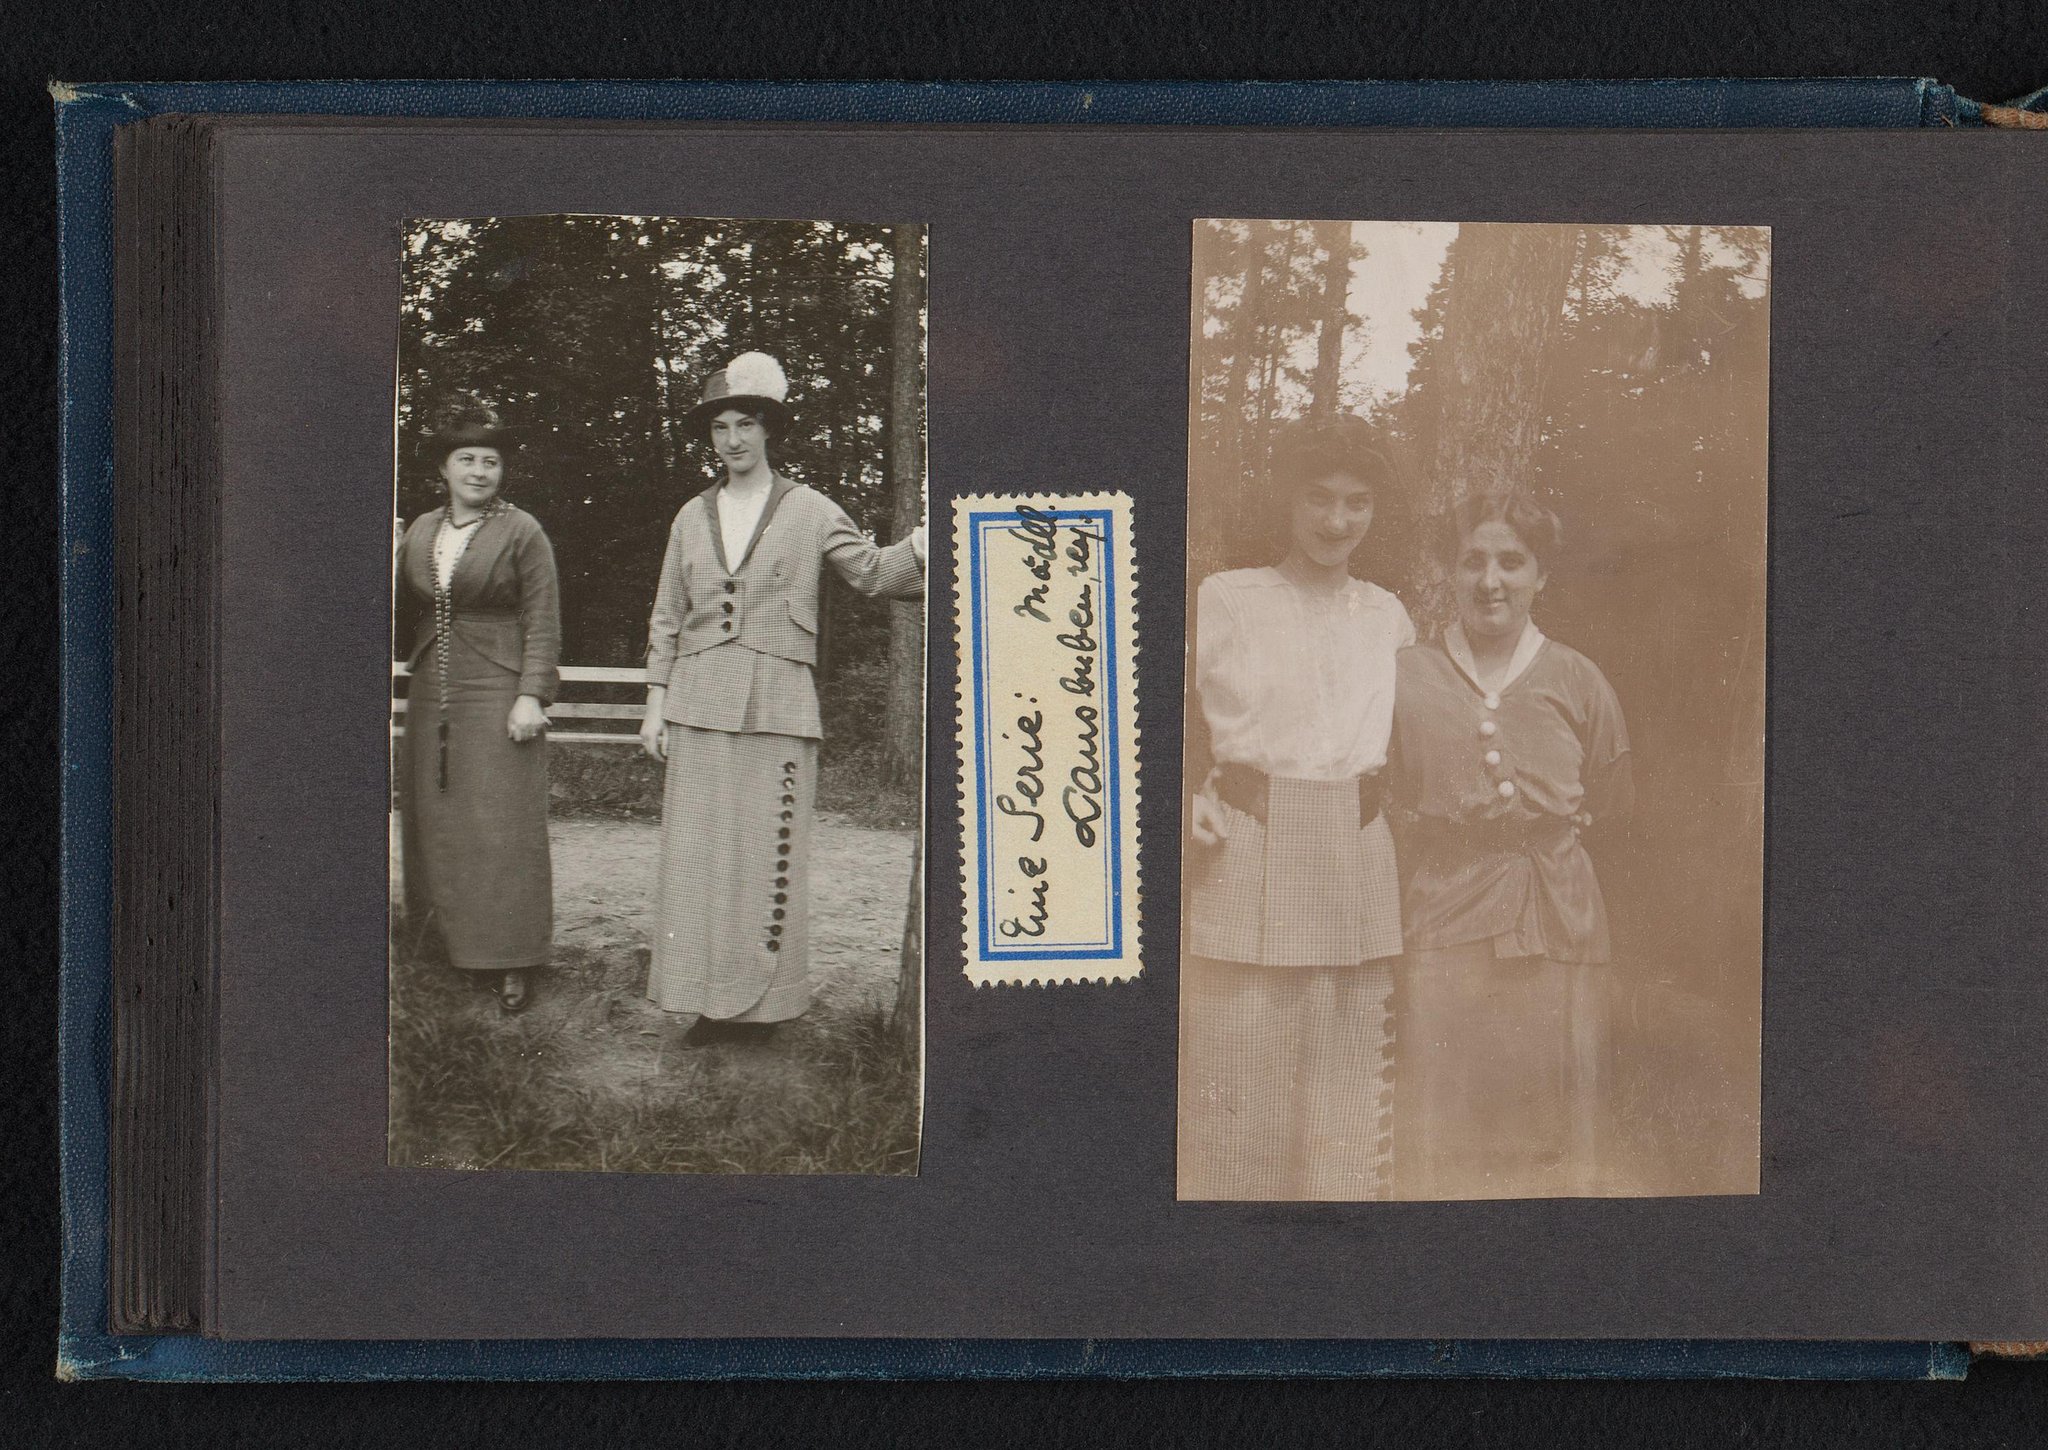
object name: album leaf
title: Else en vriendinnen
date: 1914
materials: paper, photographic support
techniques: gelatin silver print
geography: germany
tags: else wachenheimer-moos, outing, pleasure trip, germany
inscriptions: inscription: ‘Eine Serie: Mädel ...’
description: Albumblad met twee foto's van Else met vriendinnen. Onderdeel van het fotoalbum van Else Wachenheimer-Moos en haar broers Arthur en Willy Moos en anderen in de periode 1913-1918.